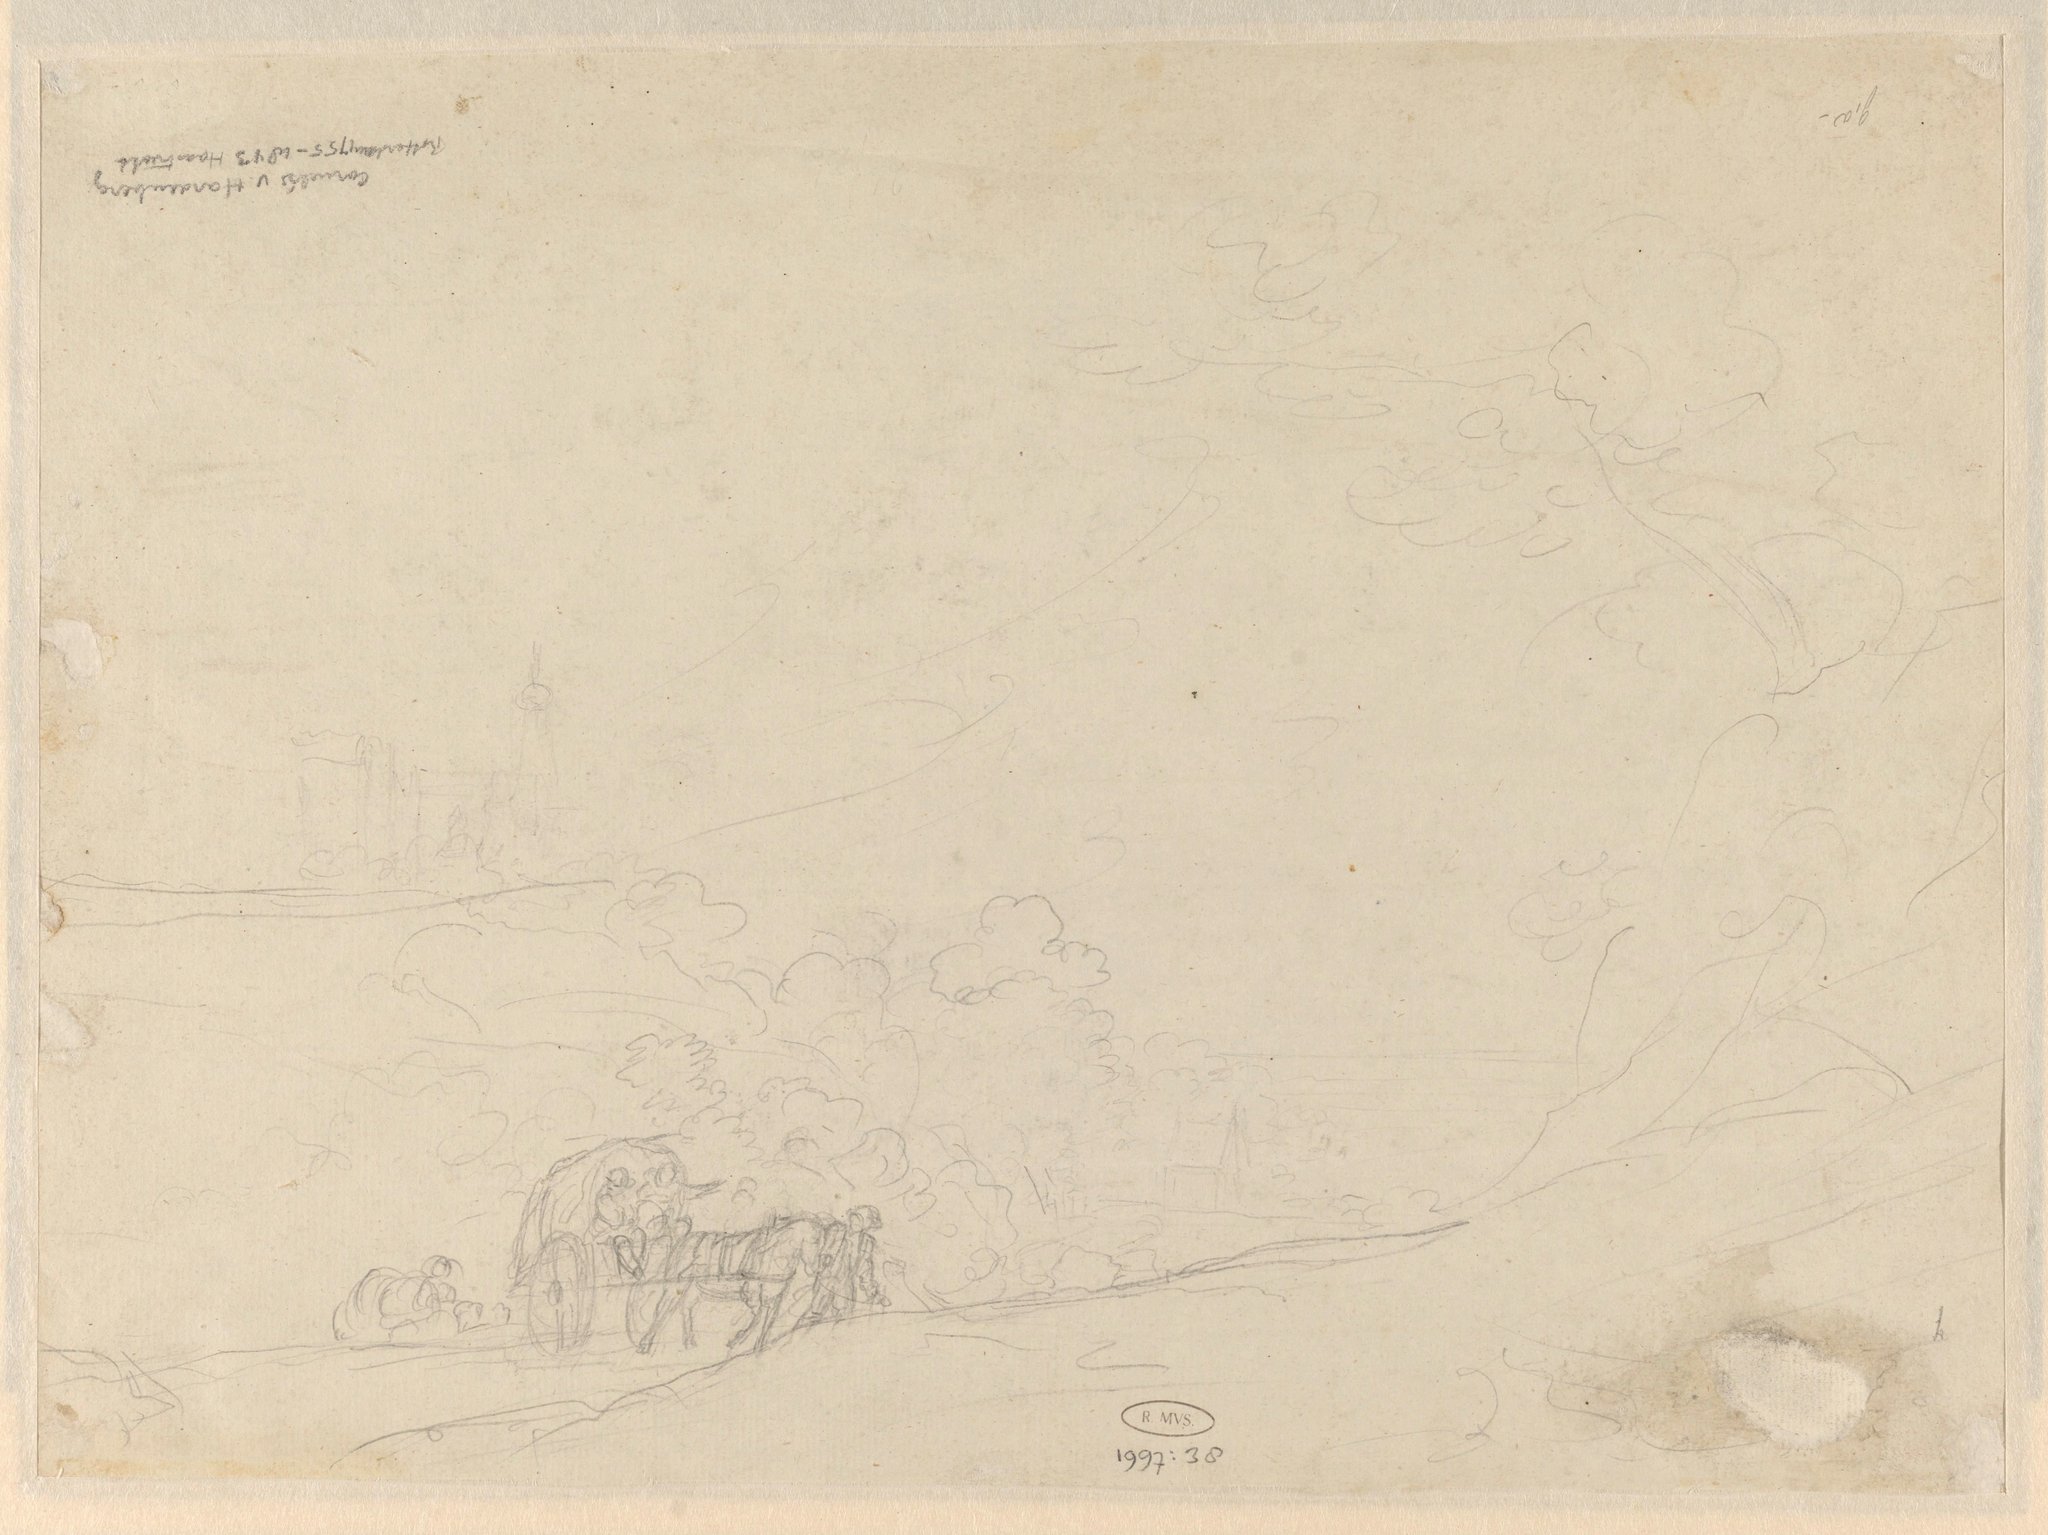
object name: drawing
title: Reizigers in een huifkar steken een rivier over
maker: cornelis van hardenbergh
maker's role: draughtsman, painter, print maker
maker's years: 1755-1843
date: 1765-1843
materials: paper, pencil